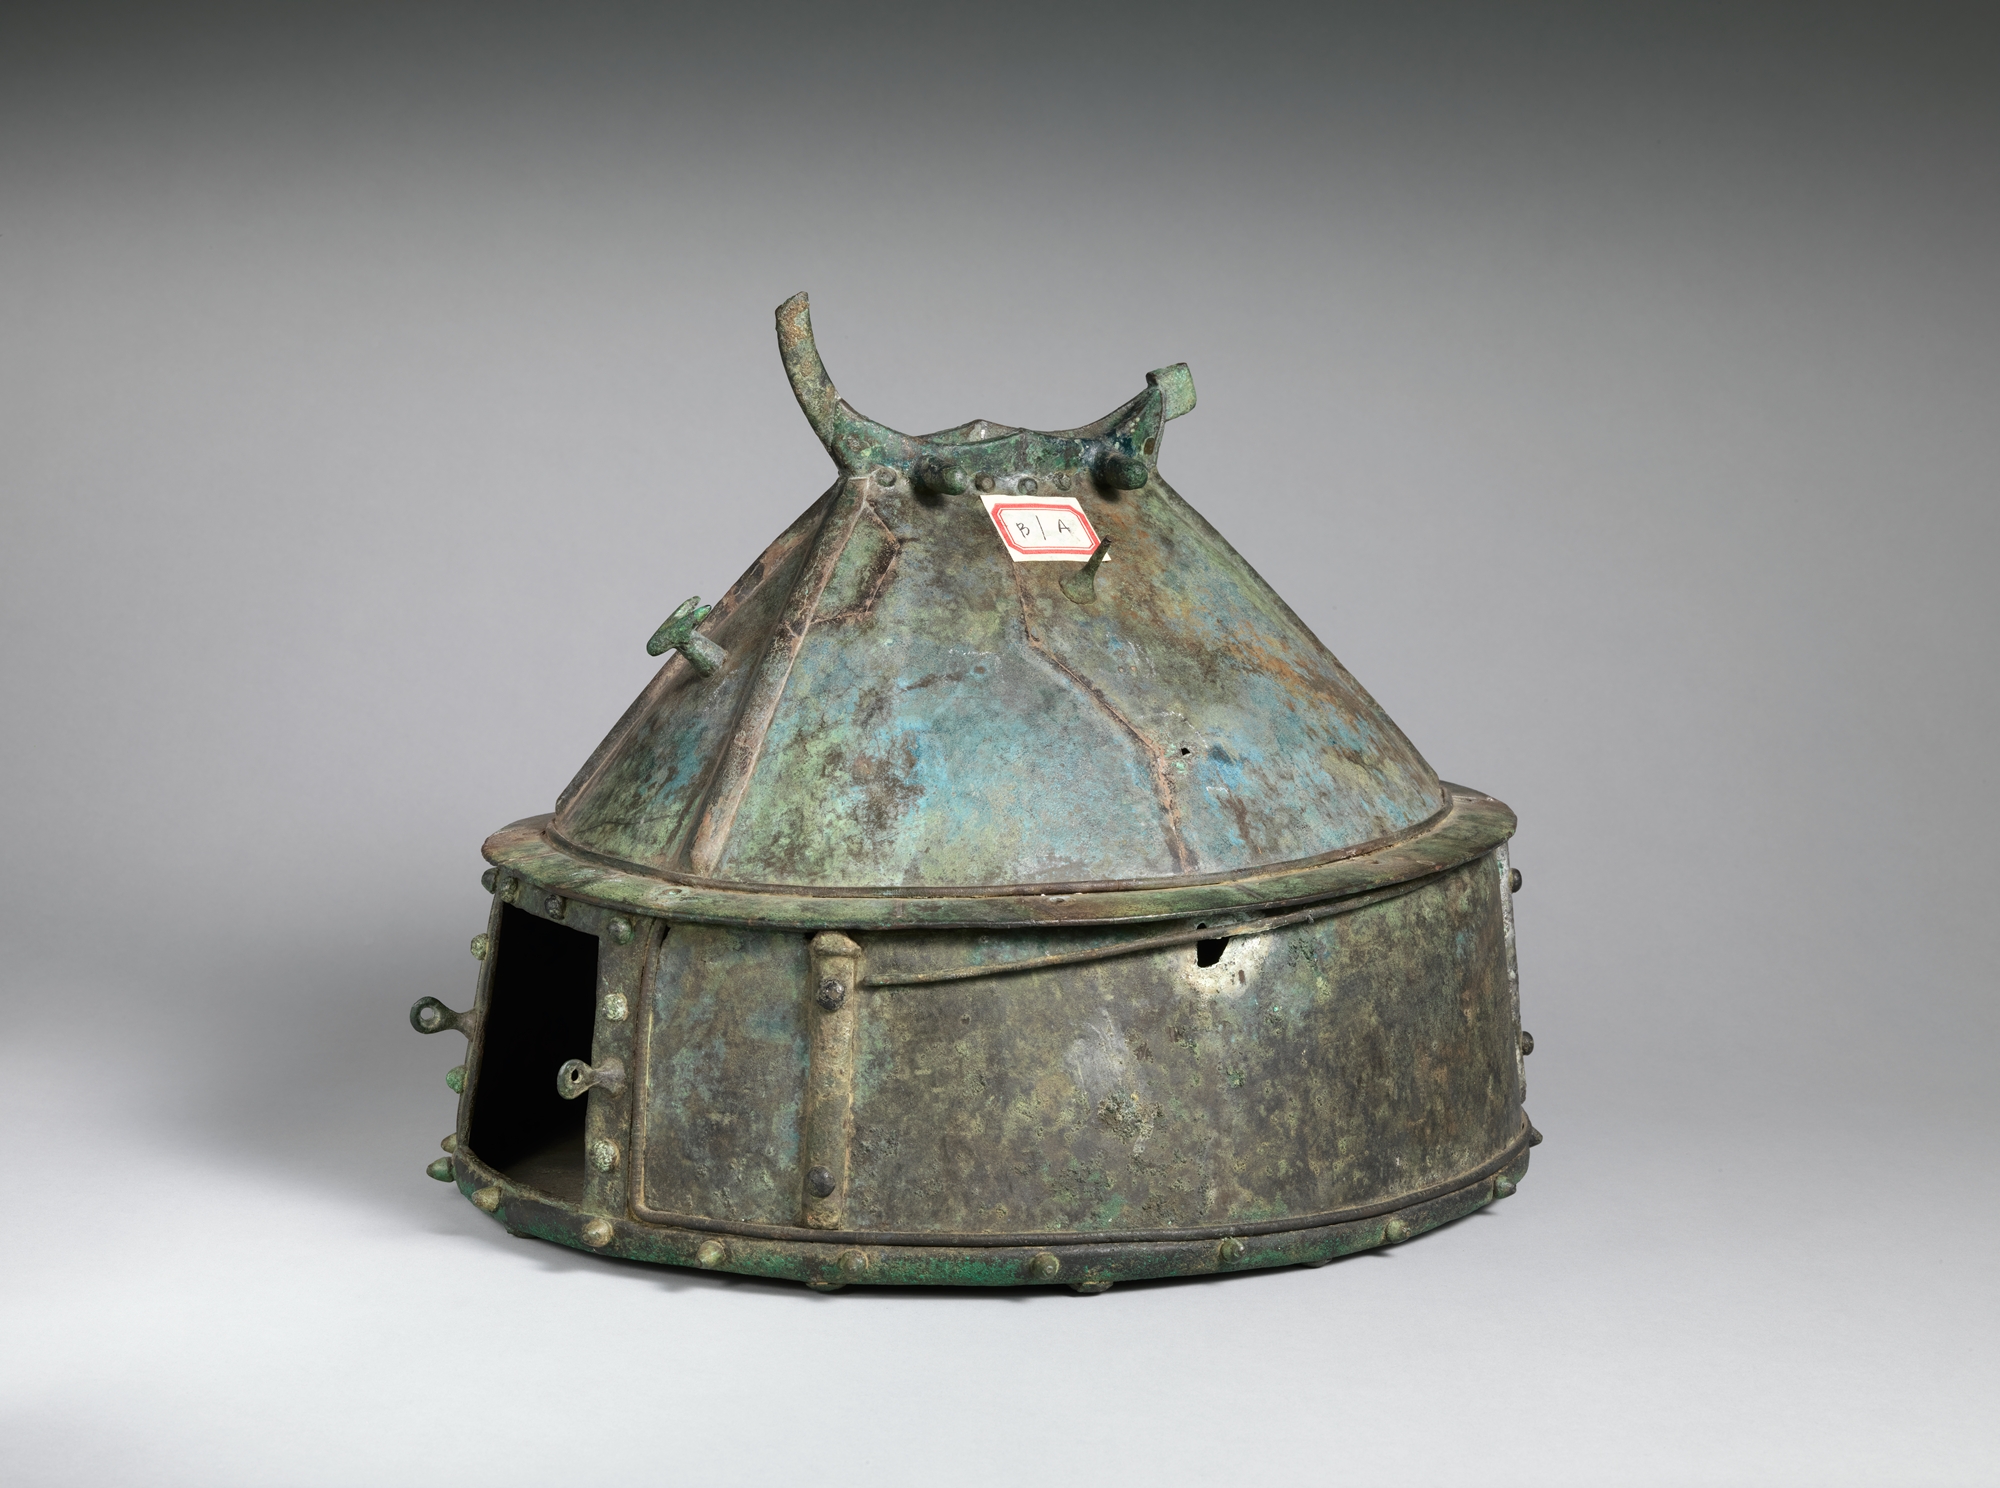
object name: urn in the form of a hut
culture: villanovan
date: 1300-1950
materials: bronze